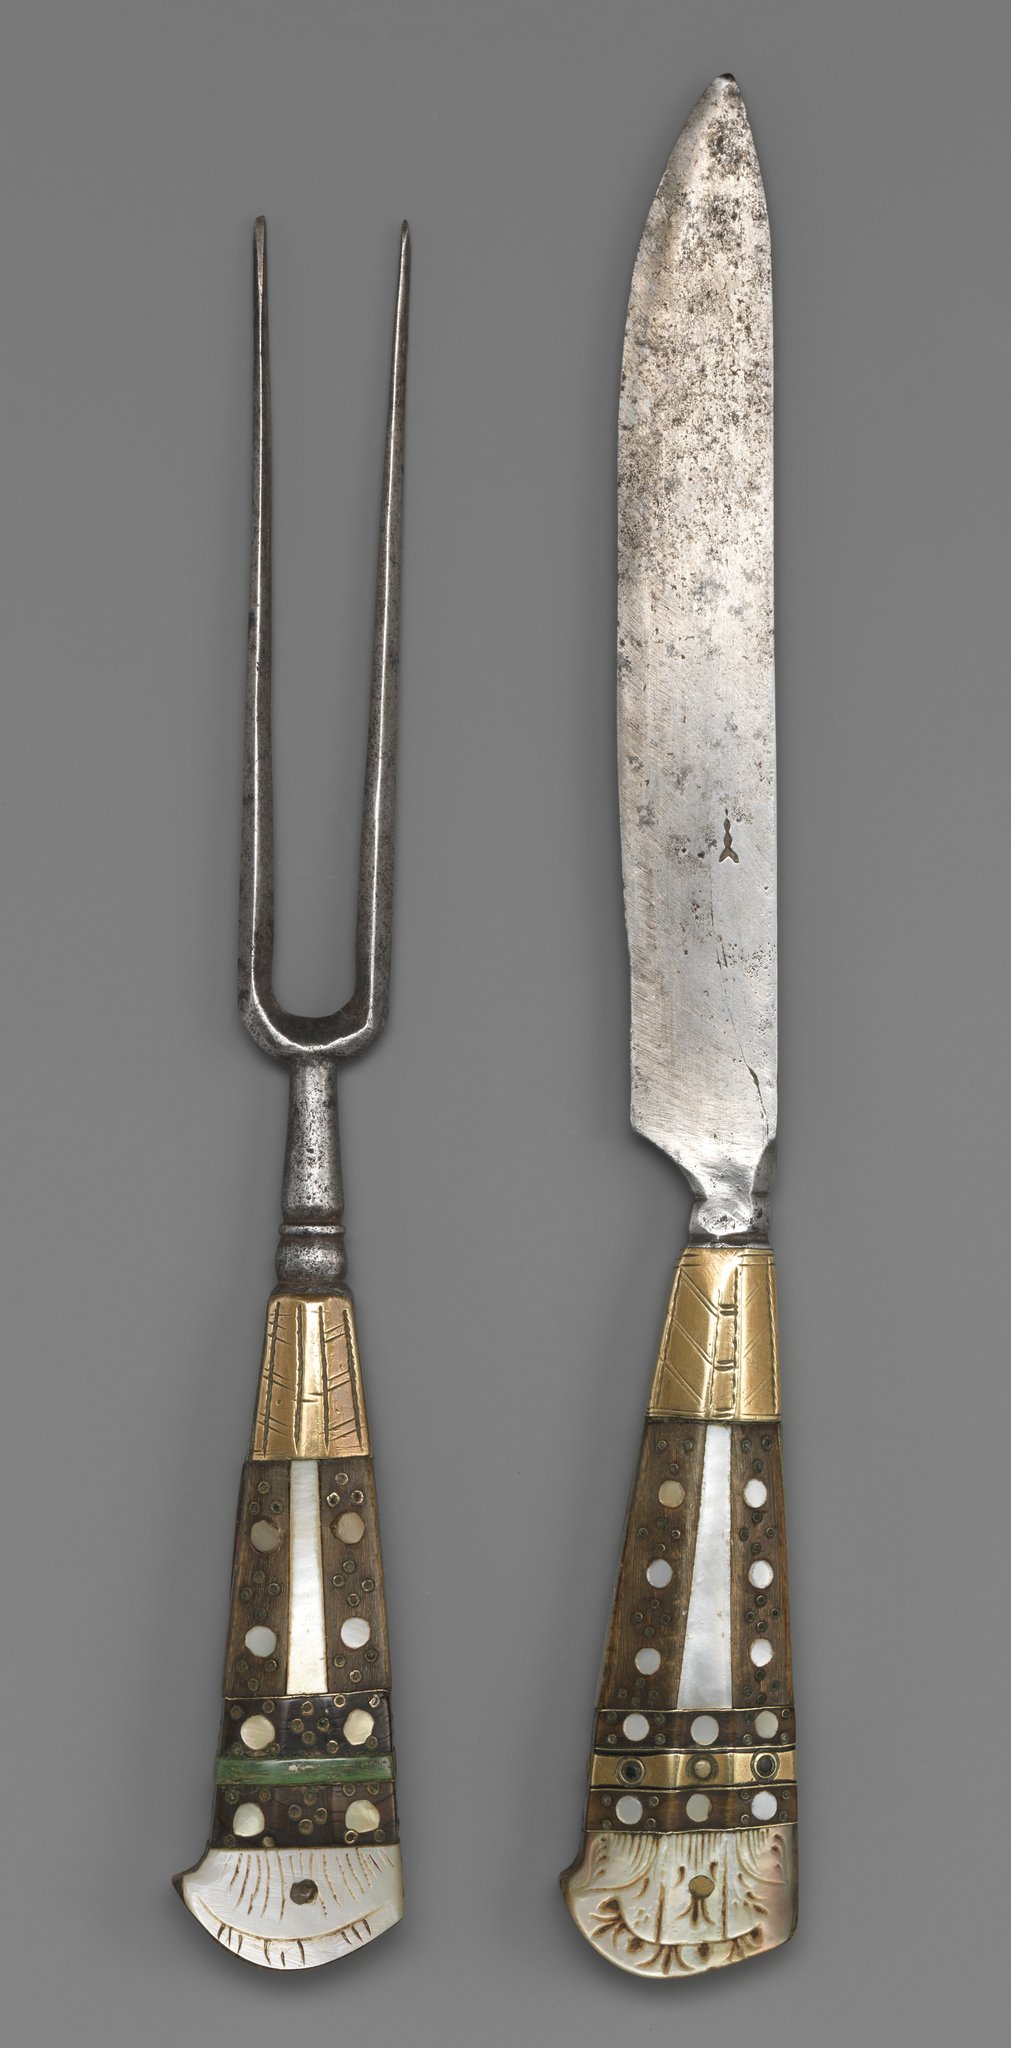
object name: fork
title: Table fork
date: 1701-1800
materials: metal, mother of pearl, steel, wood